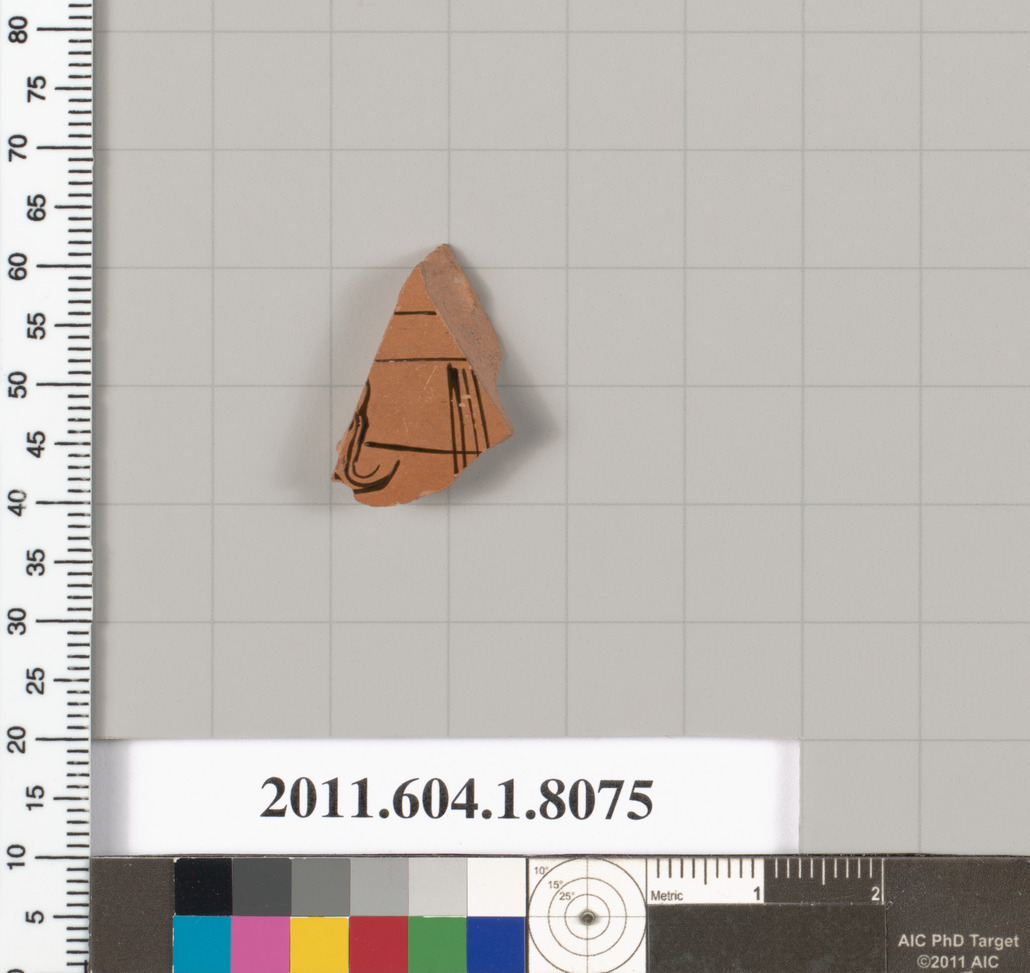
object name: kylix fragment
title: Terracotta fragment of a kylix (drinking cup)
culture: greek, attic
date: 510-500 BCE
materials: terracotta